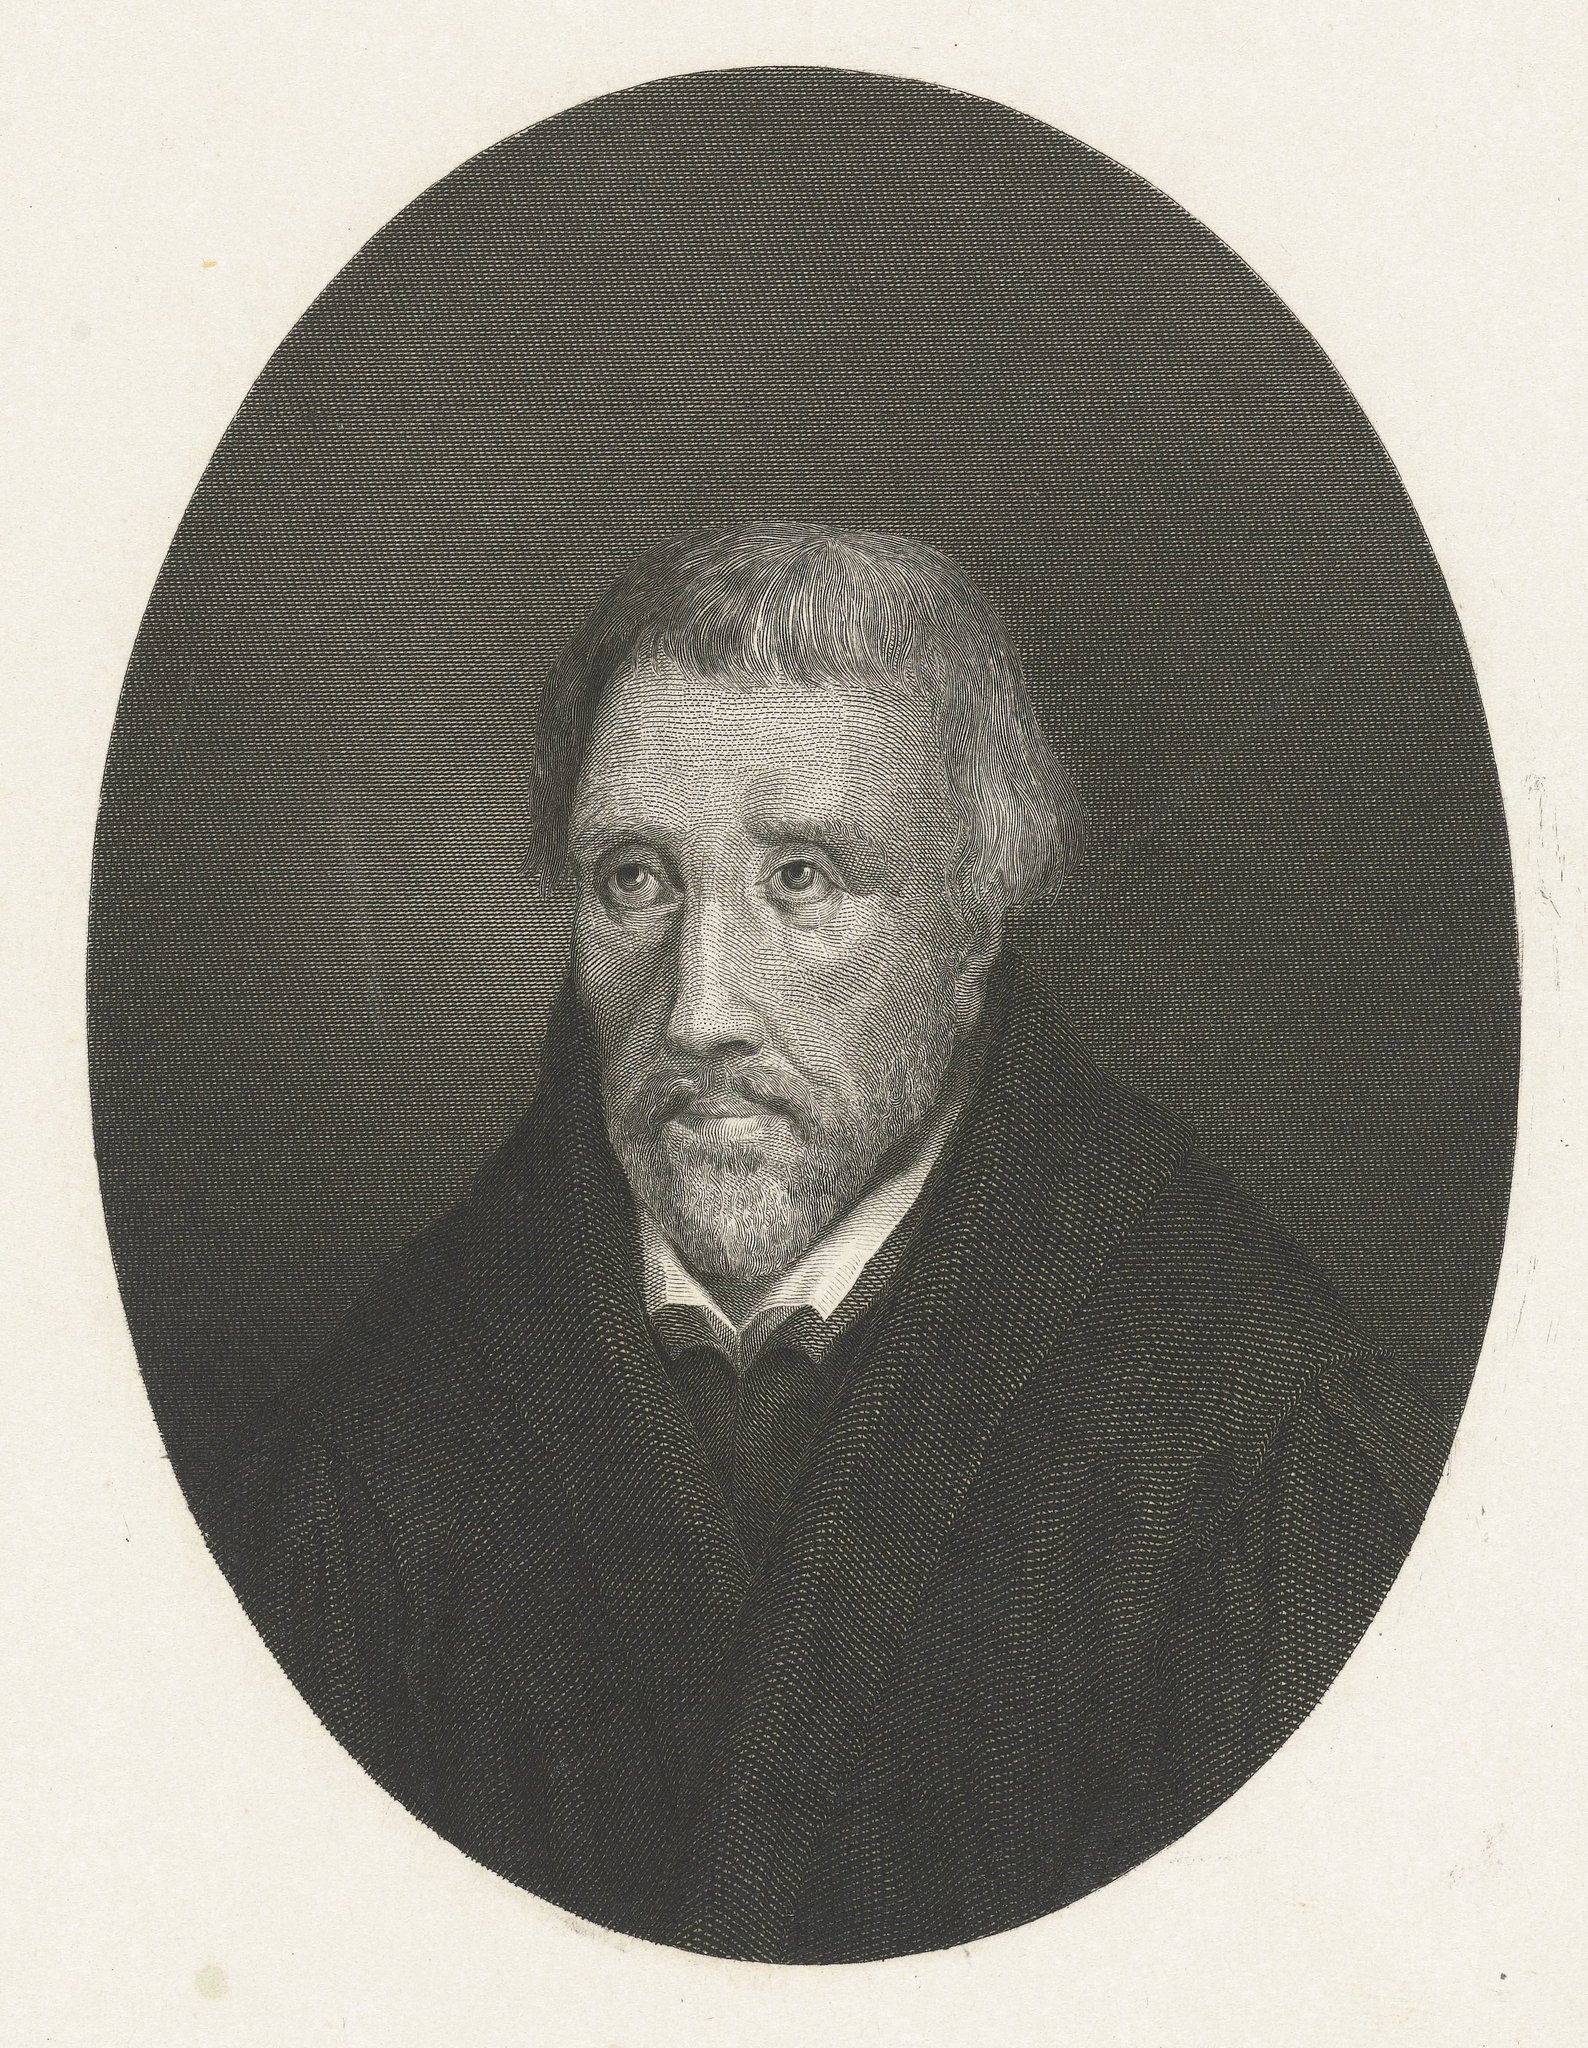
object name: print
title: Mansbuste in ovaal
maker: henricus wilhelmus couwenberg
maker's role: draughtsman, print maker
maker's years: 1814-1845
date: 1829-1845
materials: paper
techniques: engraving, etching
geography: amsterdam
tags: anonymous historical person portrayed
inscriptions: collector's mark: Lugt 2228